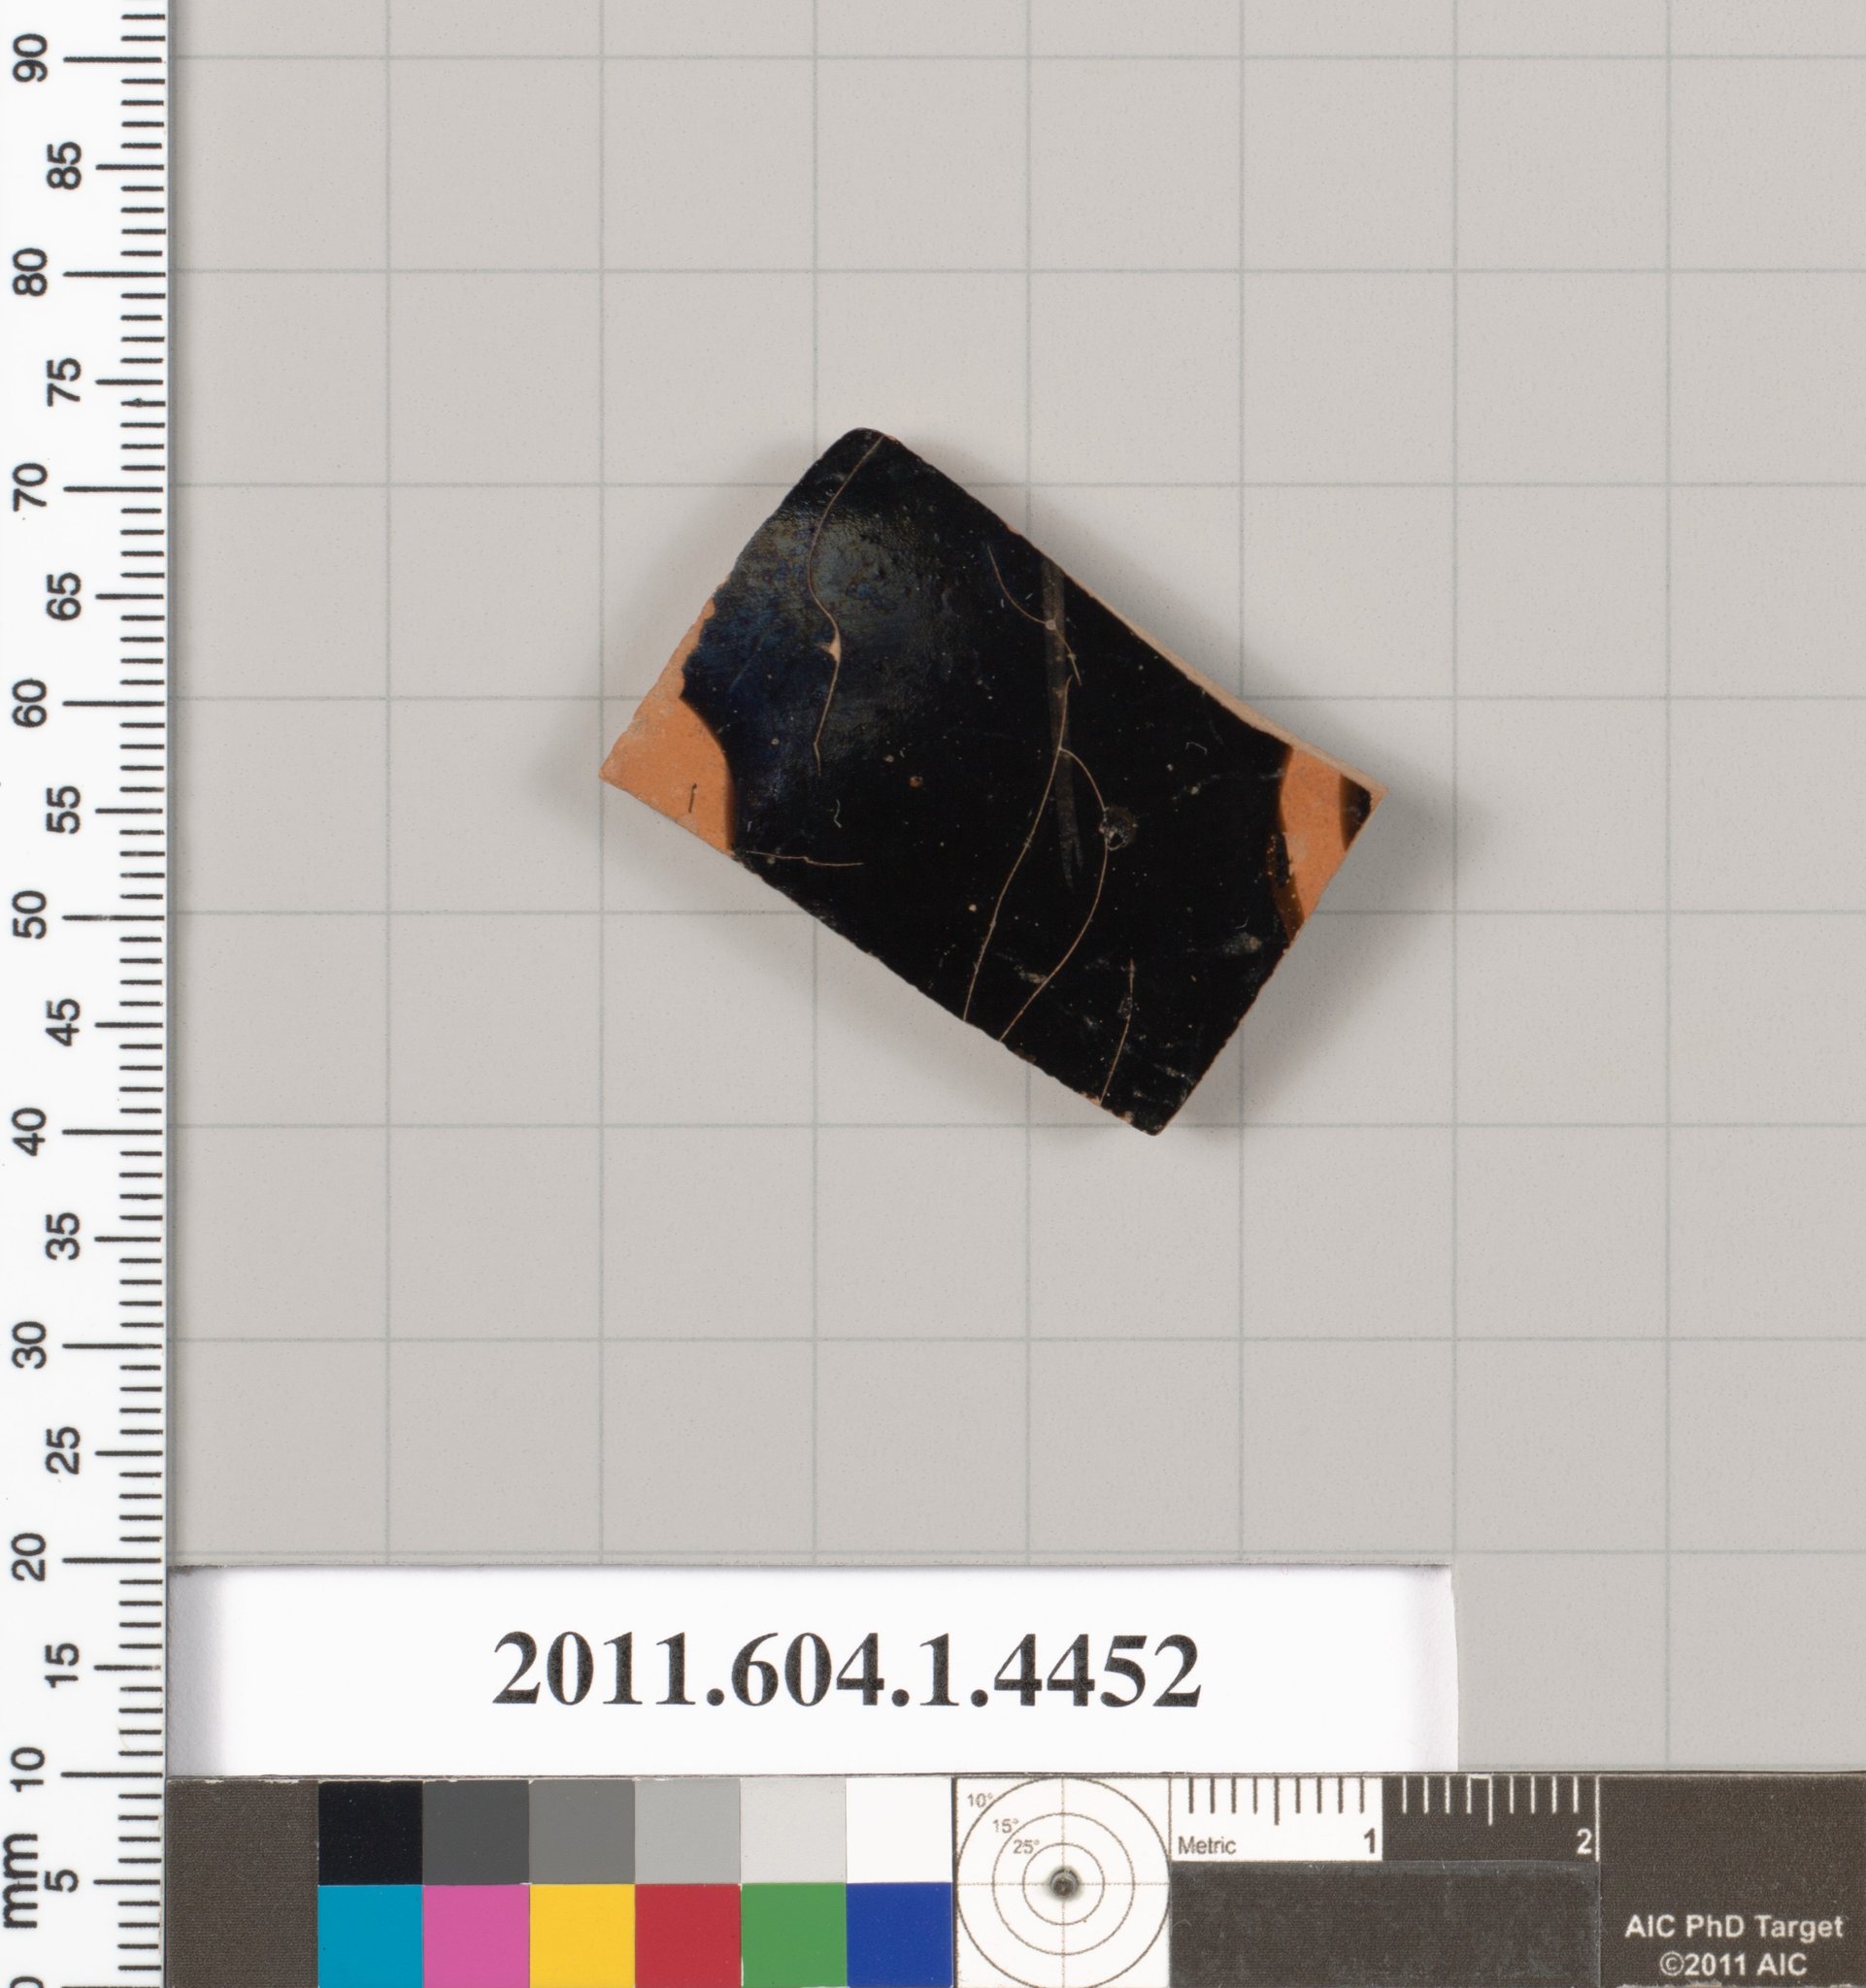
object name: kylix fragment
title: Terracotta fragment of a kylix (drinking cup)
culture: greek, attic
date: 467-435 BCE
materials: terracotta